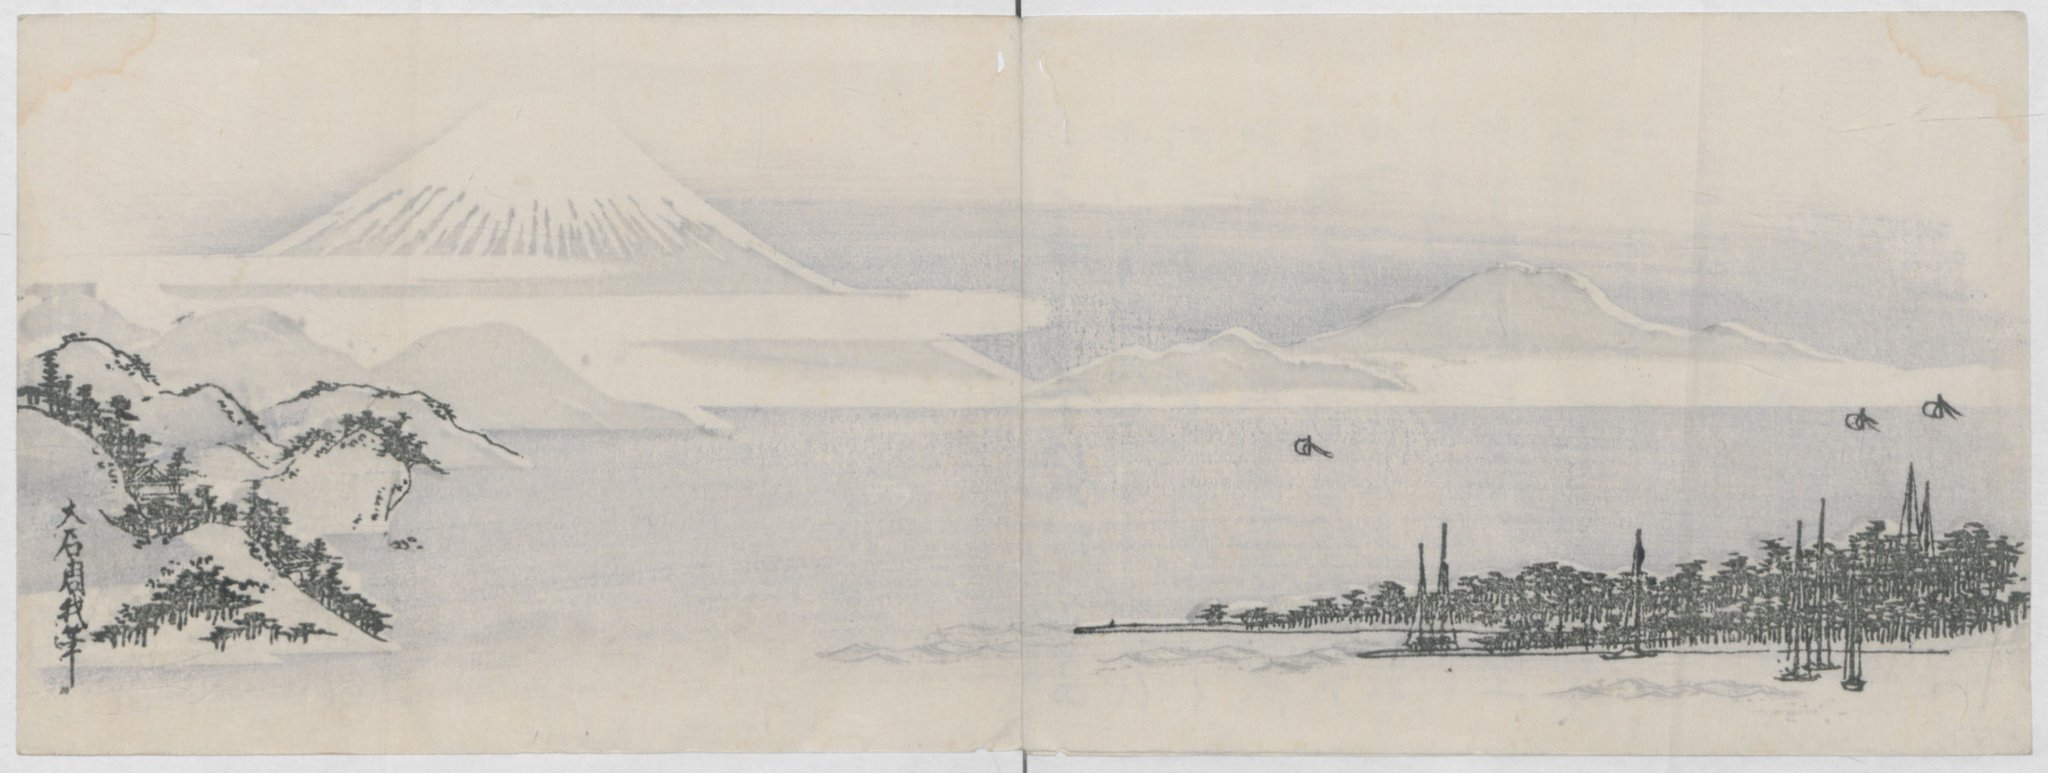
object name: illustrated book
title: Real Figures of the King of Mountains (Sannō shinkei) 山王真形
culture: japanese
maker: ōishi shūga 大石周我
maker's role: artist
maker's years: 1752-1852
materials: ink, paper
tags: mountains,snow